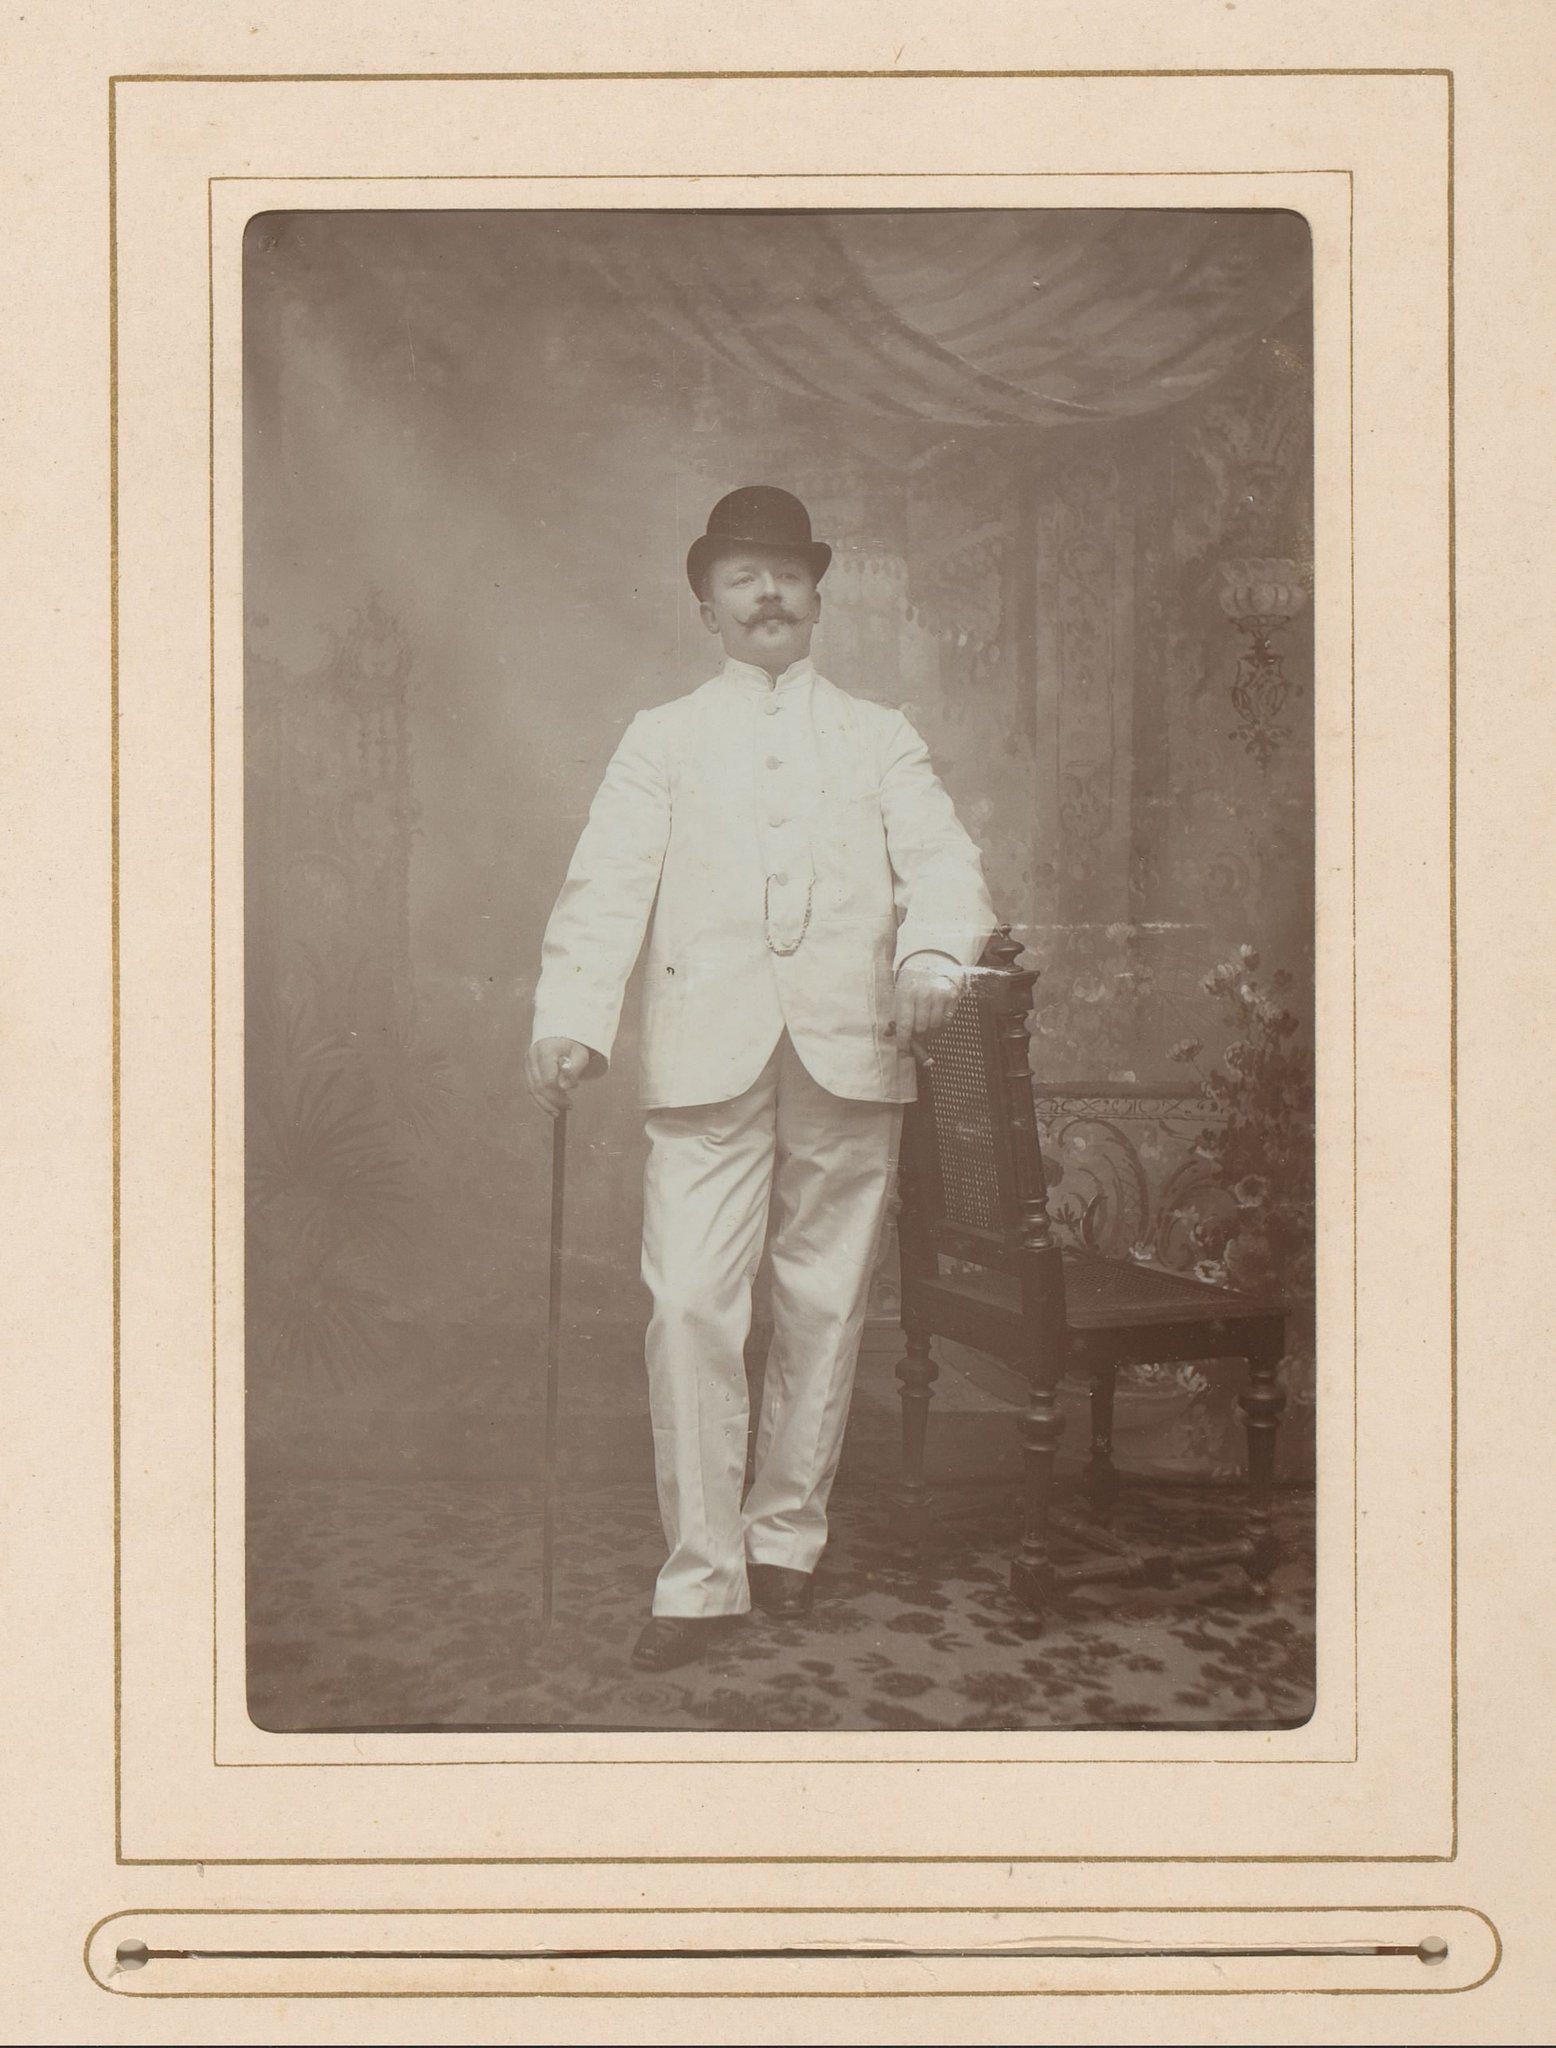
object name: photograph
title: Portret van een man met snor en bolhoed, aangeduid als Dirk de Roever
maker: nicolaas schuitvlot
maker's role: fotograaf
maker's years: 1859-1947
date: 1883-1903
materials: cardboard, photographic support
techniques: collodion silver print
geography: amsterdam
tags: historical persons, head-gear: hat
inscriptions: name: ‘Dirk de Roever’, inscription: ‘Nic. Schuitvlot/ Photografisch-Atelier/ Amsterdam/ Paleisstraat/ bij den Dam No.5’, name: ‘Dirk de Roever’